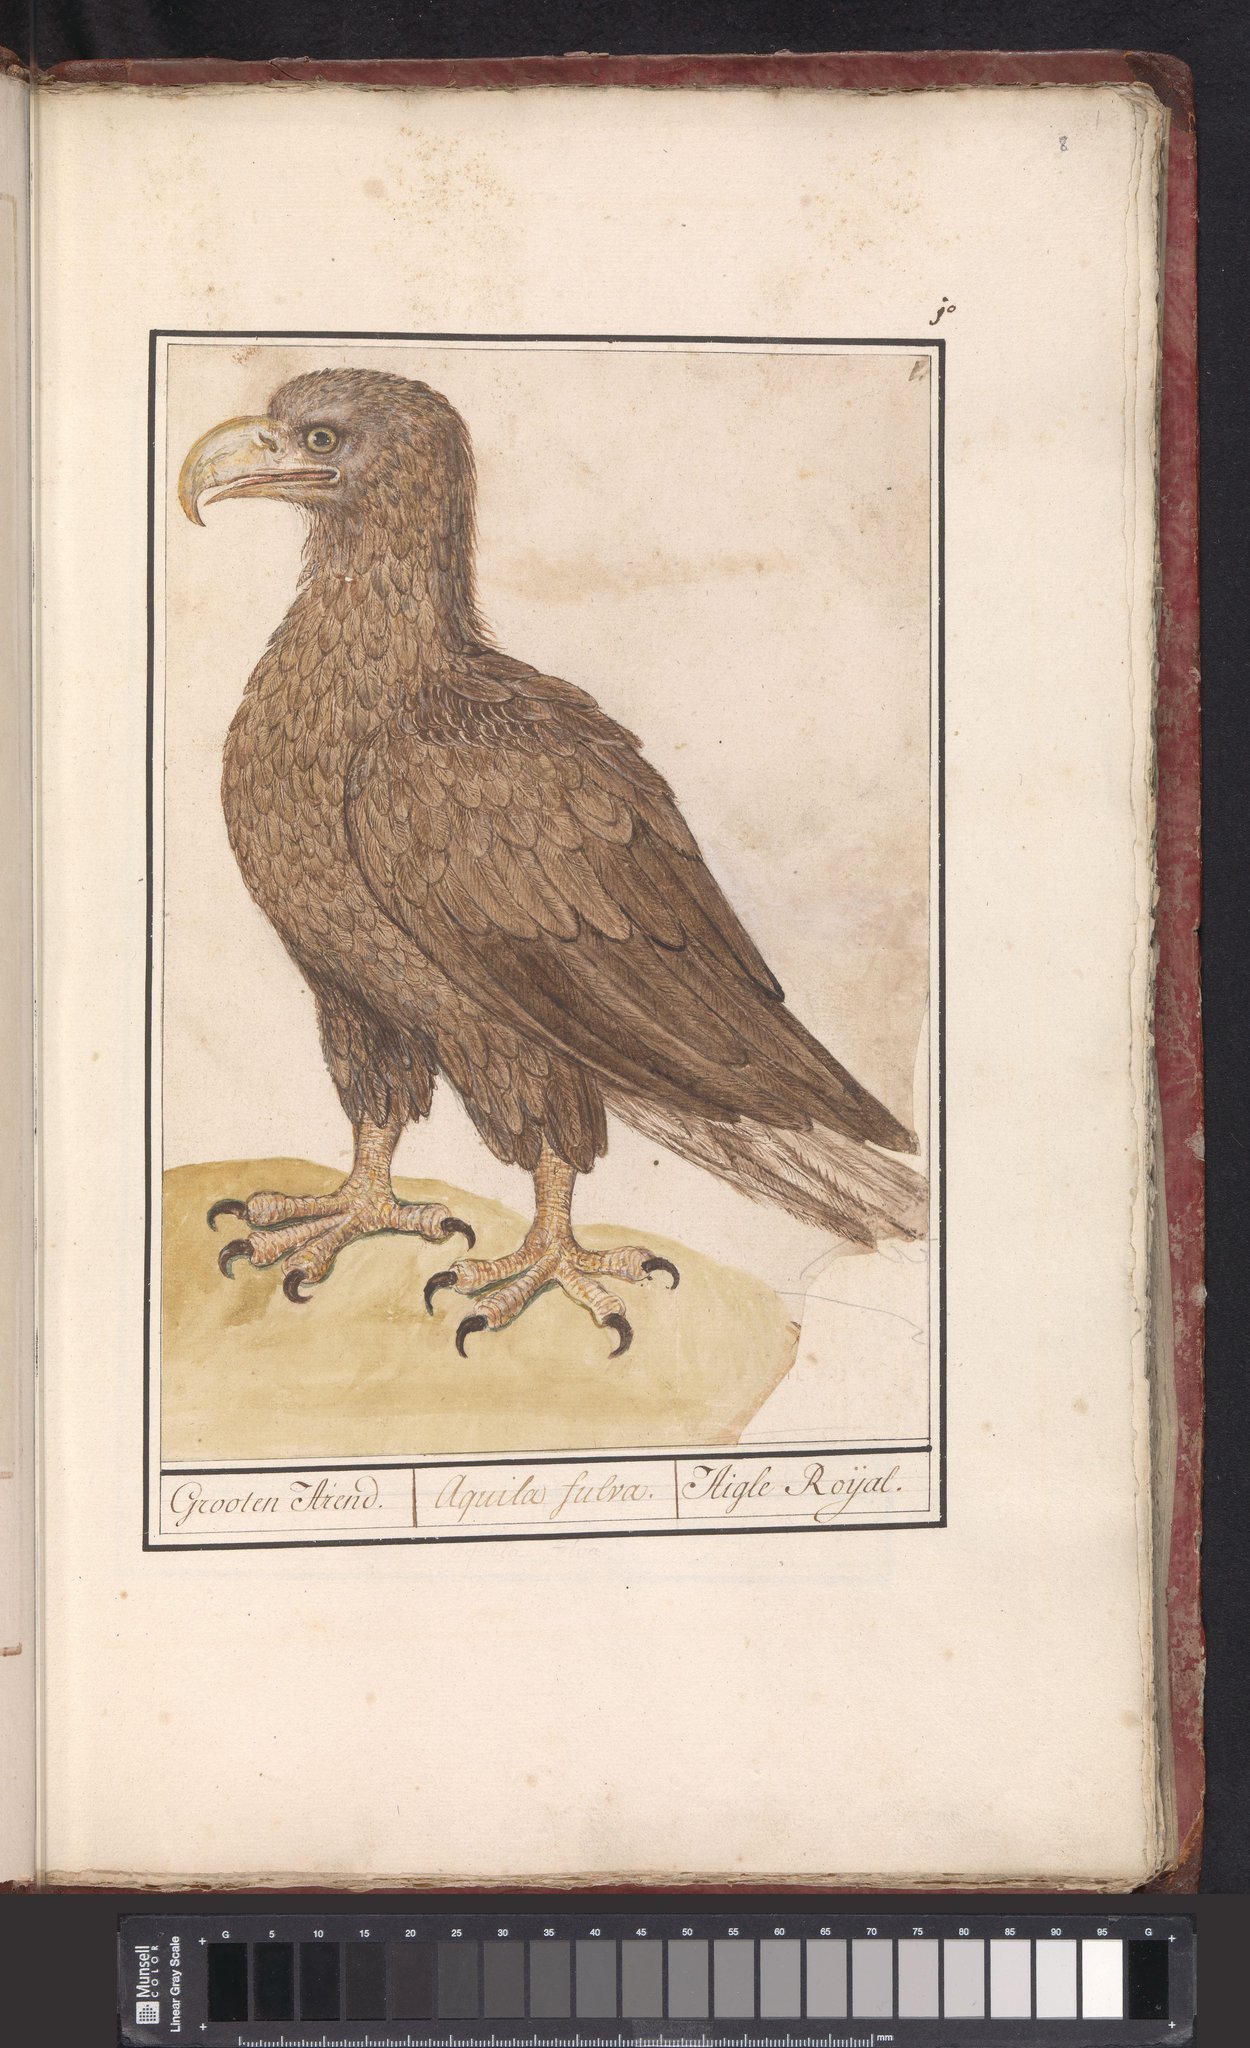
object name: drawing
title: White-tailed eagle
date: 1596-1610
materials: paint, paper, pencil, watercolor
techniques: brush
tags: predatory birds: white-tailed eagle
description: Zeearend. Genummerd rechtsboven: 1. Onderdeel van het eerste album met tekeningen van vogels. Derde van twaalf albums met tekeningen van dieren, vogels en planten bekend rond 1600, gemaakt in opdracht van keizer Rudolf II. Met toelichting in Nederlands, Latijn en Frans.